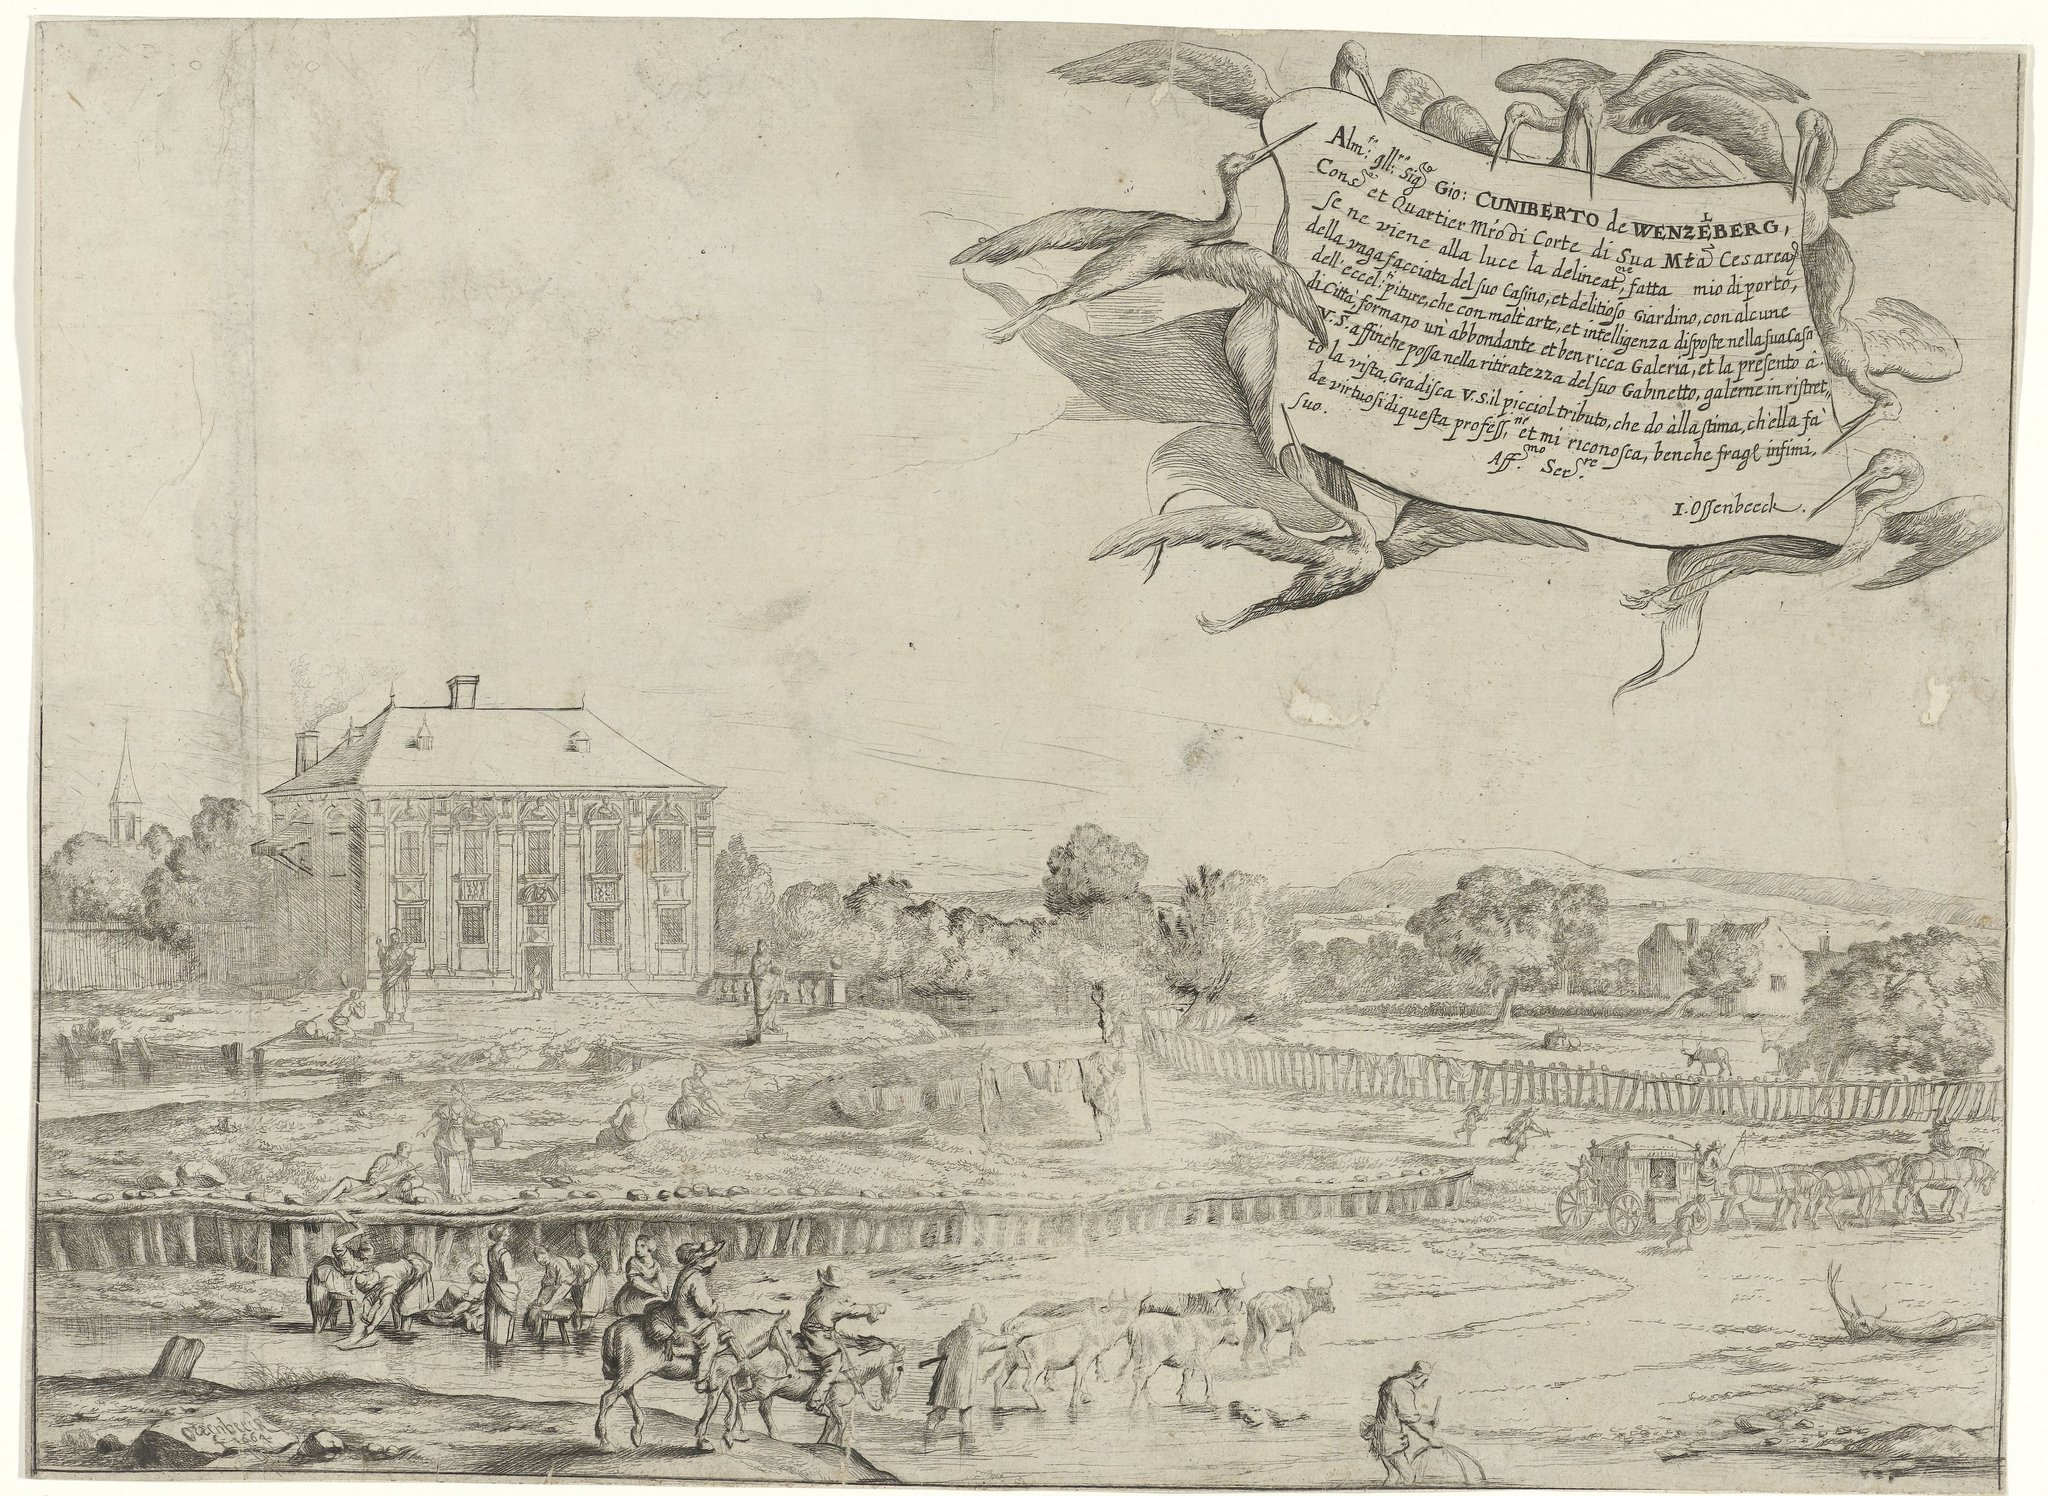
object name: print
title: Zomerhuis van Cunibert van Wenzelsberg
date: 1664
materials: paper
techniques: engraving, etching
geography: vienna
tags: ford, rural housing, e.g. country-house, villa, cottage, hanging the wash to dry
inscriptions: collector's mark: Lugt 2228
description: Gezicht op het zomerhuis van kwartiermaker en kunstverzamelaar Cunibert van Wenzelsberg. Voor het huis staan in de kale tuin twee beelden. Rechts is een koppel met herten. Twee ruiters en een herder met zijn koeien doorwaden een beek voor het huis. Even verderop doen vrouwen de was in de beek.